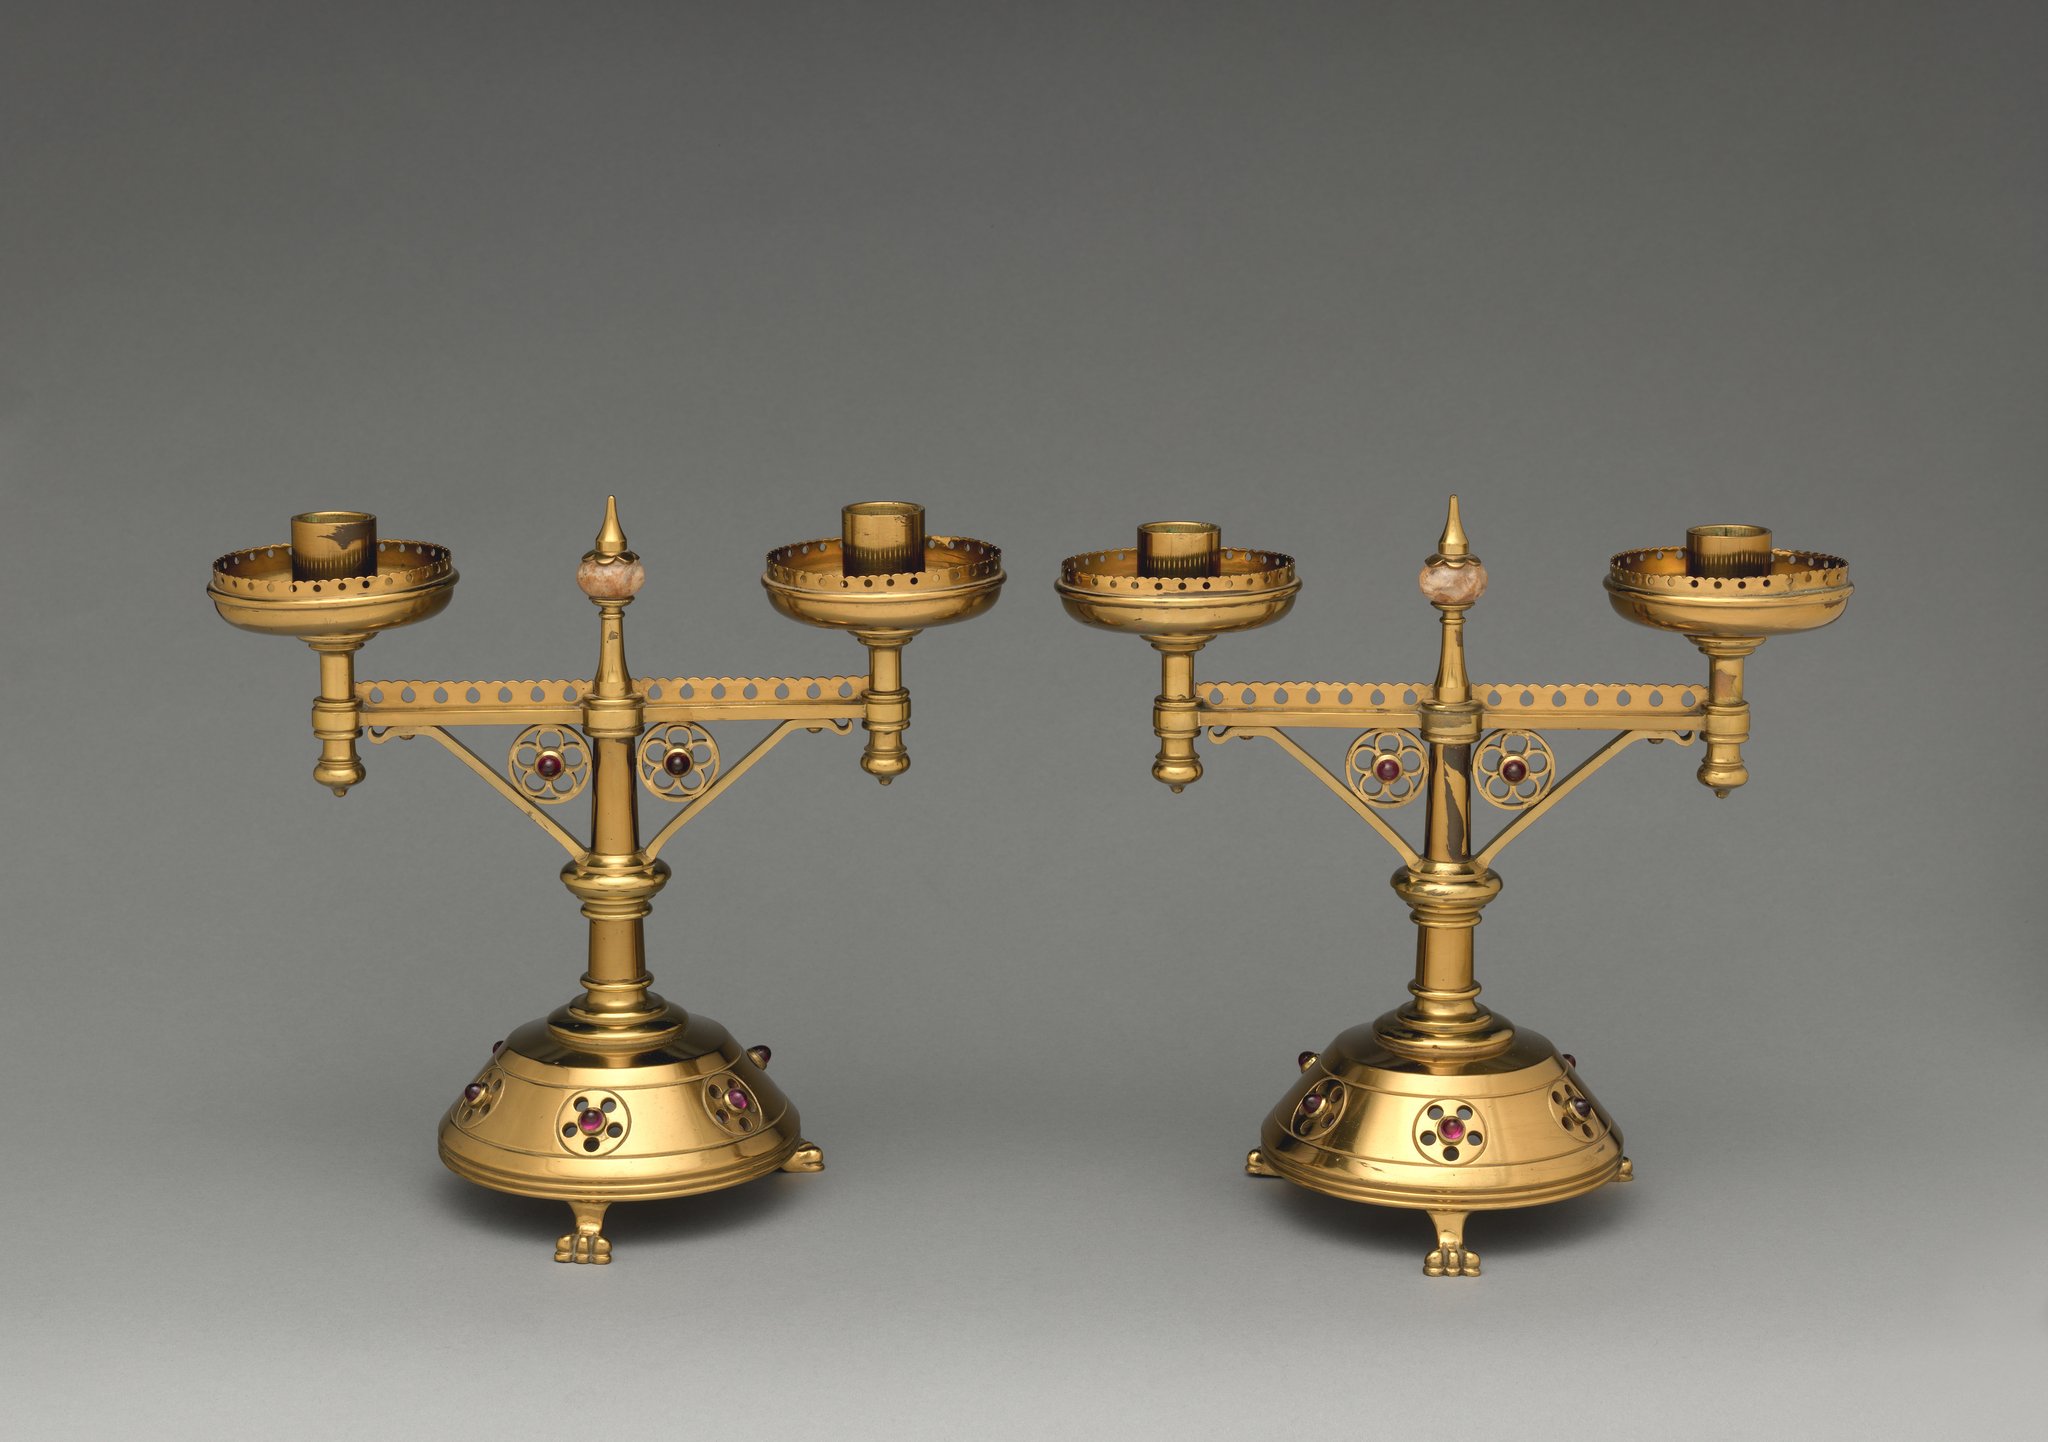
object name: candlestick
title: Candlestick (one of a pair)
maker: bruce j. talbert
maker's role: designer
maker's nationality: british, scottish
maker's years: 1838-1881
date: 1870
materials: brass, quartz